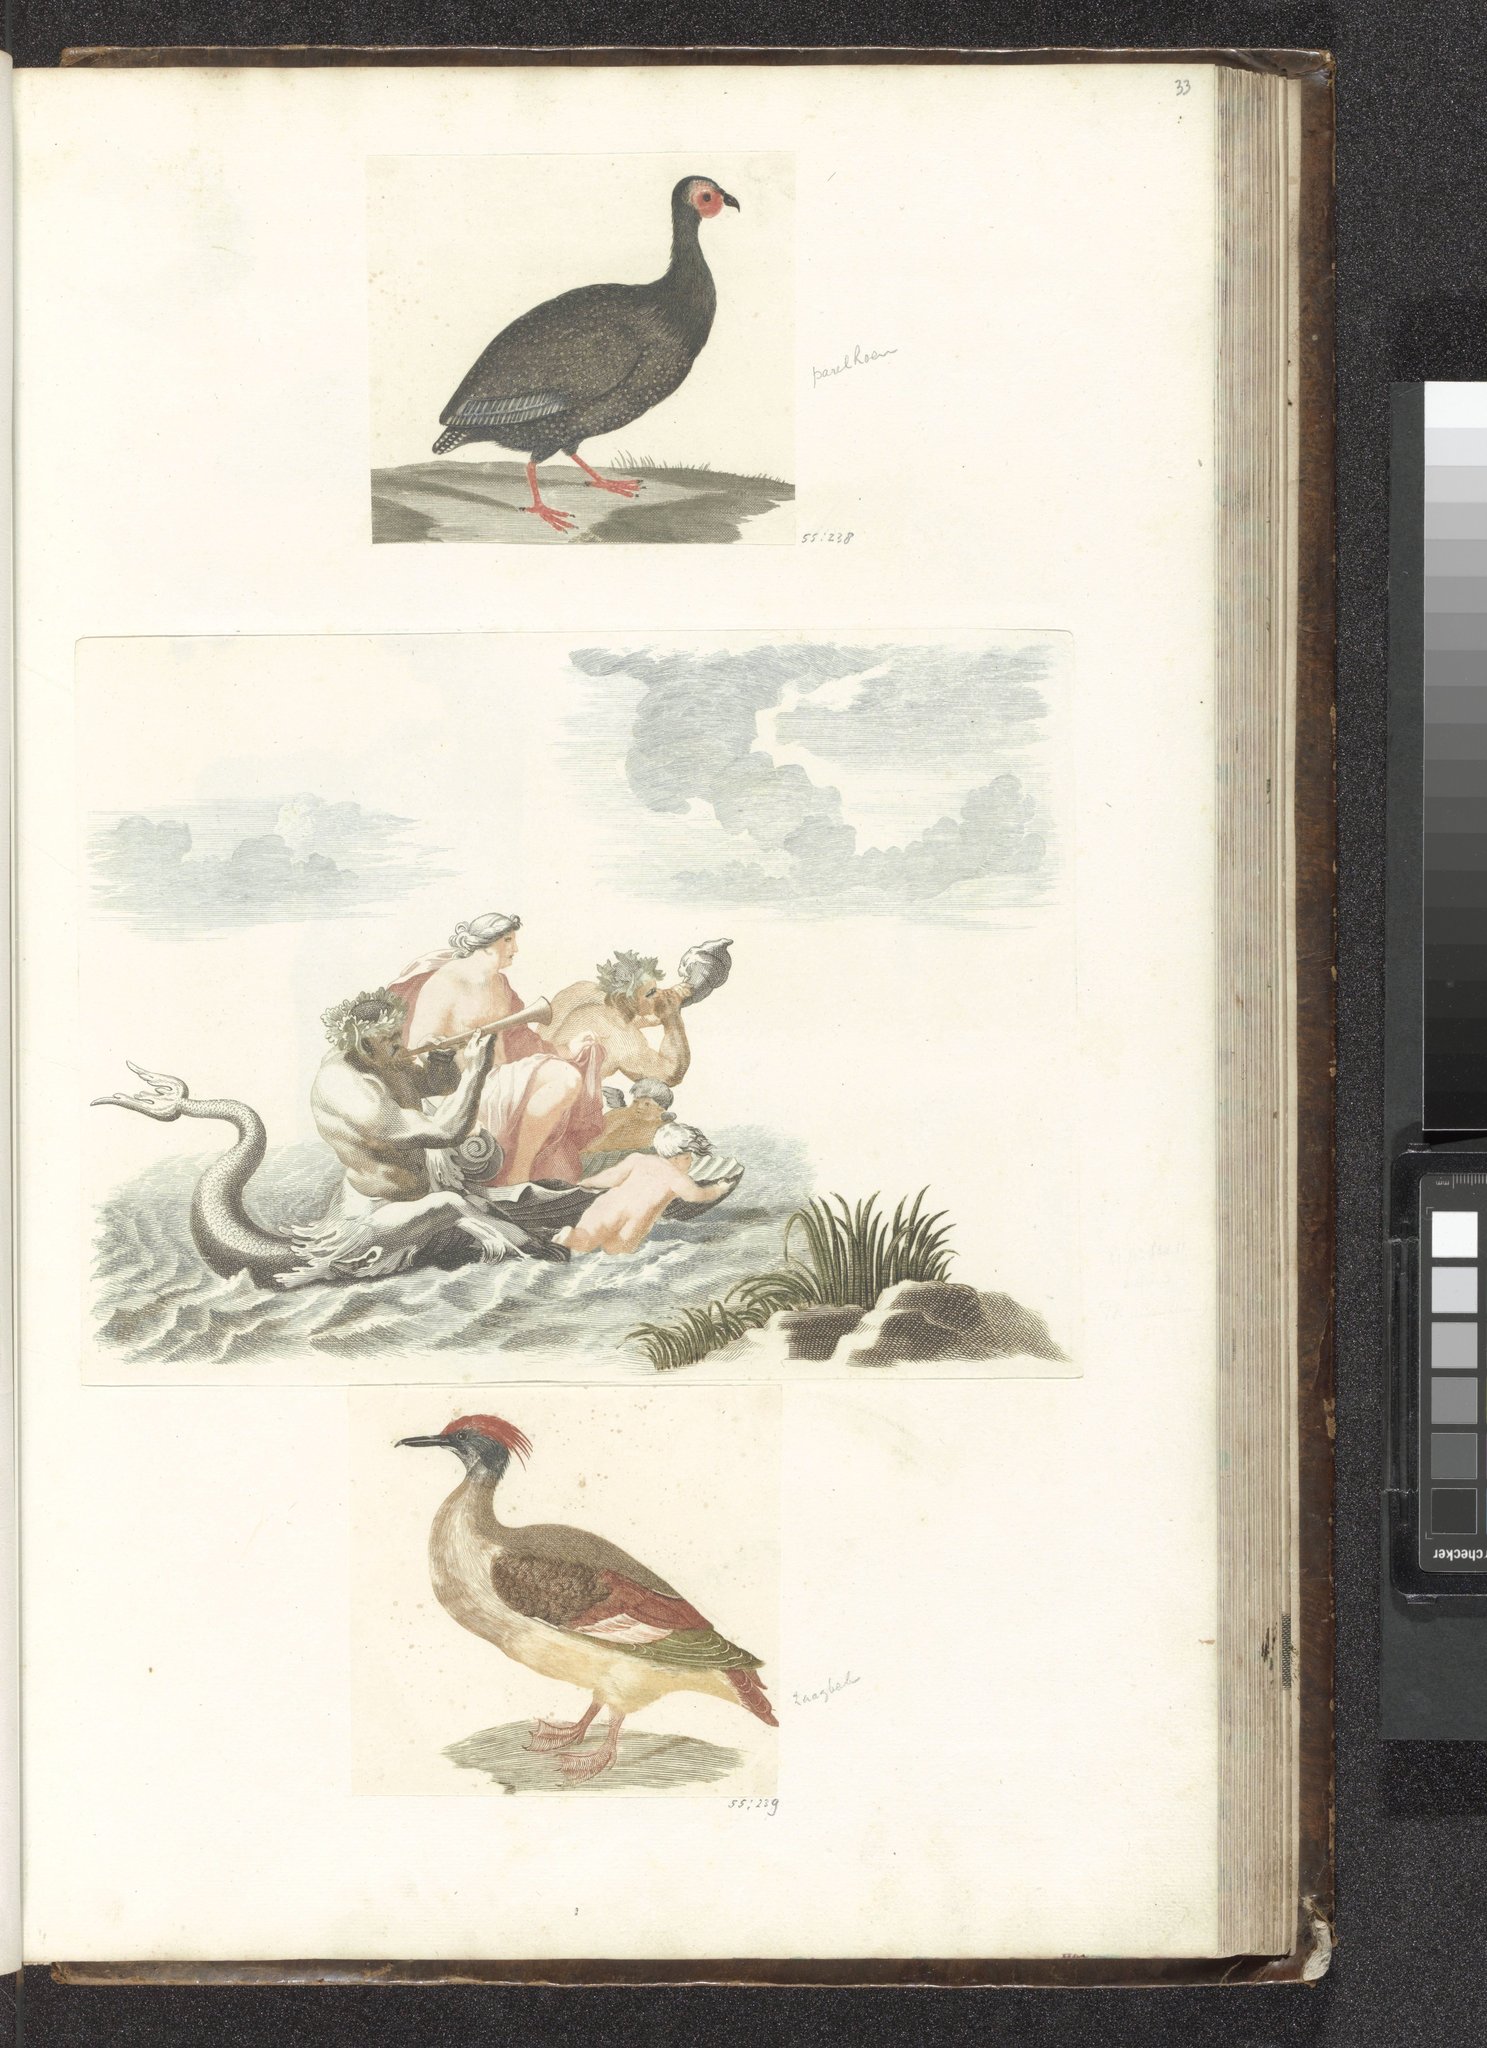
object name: album leaf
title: Galatea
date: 1688-1698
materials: paper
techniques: engraving, etching, lithography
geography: netherlands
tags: (story of) galatea; 'galatea' (ripa)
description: Galatea zit in haar hartschelp en wordt omgeven door tritons, die op hun schelp of hoorn blazen, en putti, die de schelp over zee voortbewegen. Deze prent maakt deel uit van een album.